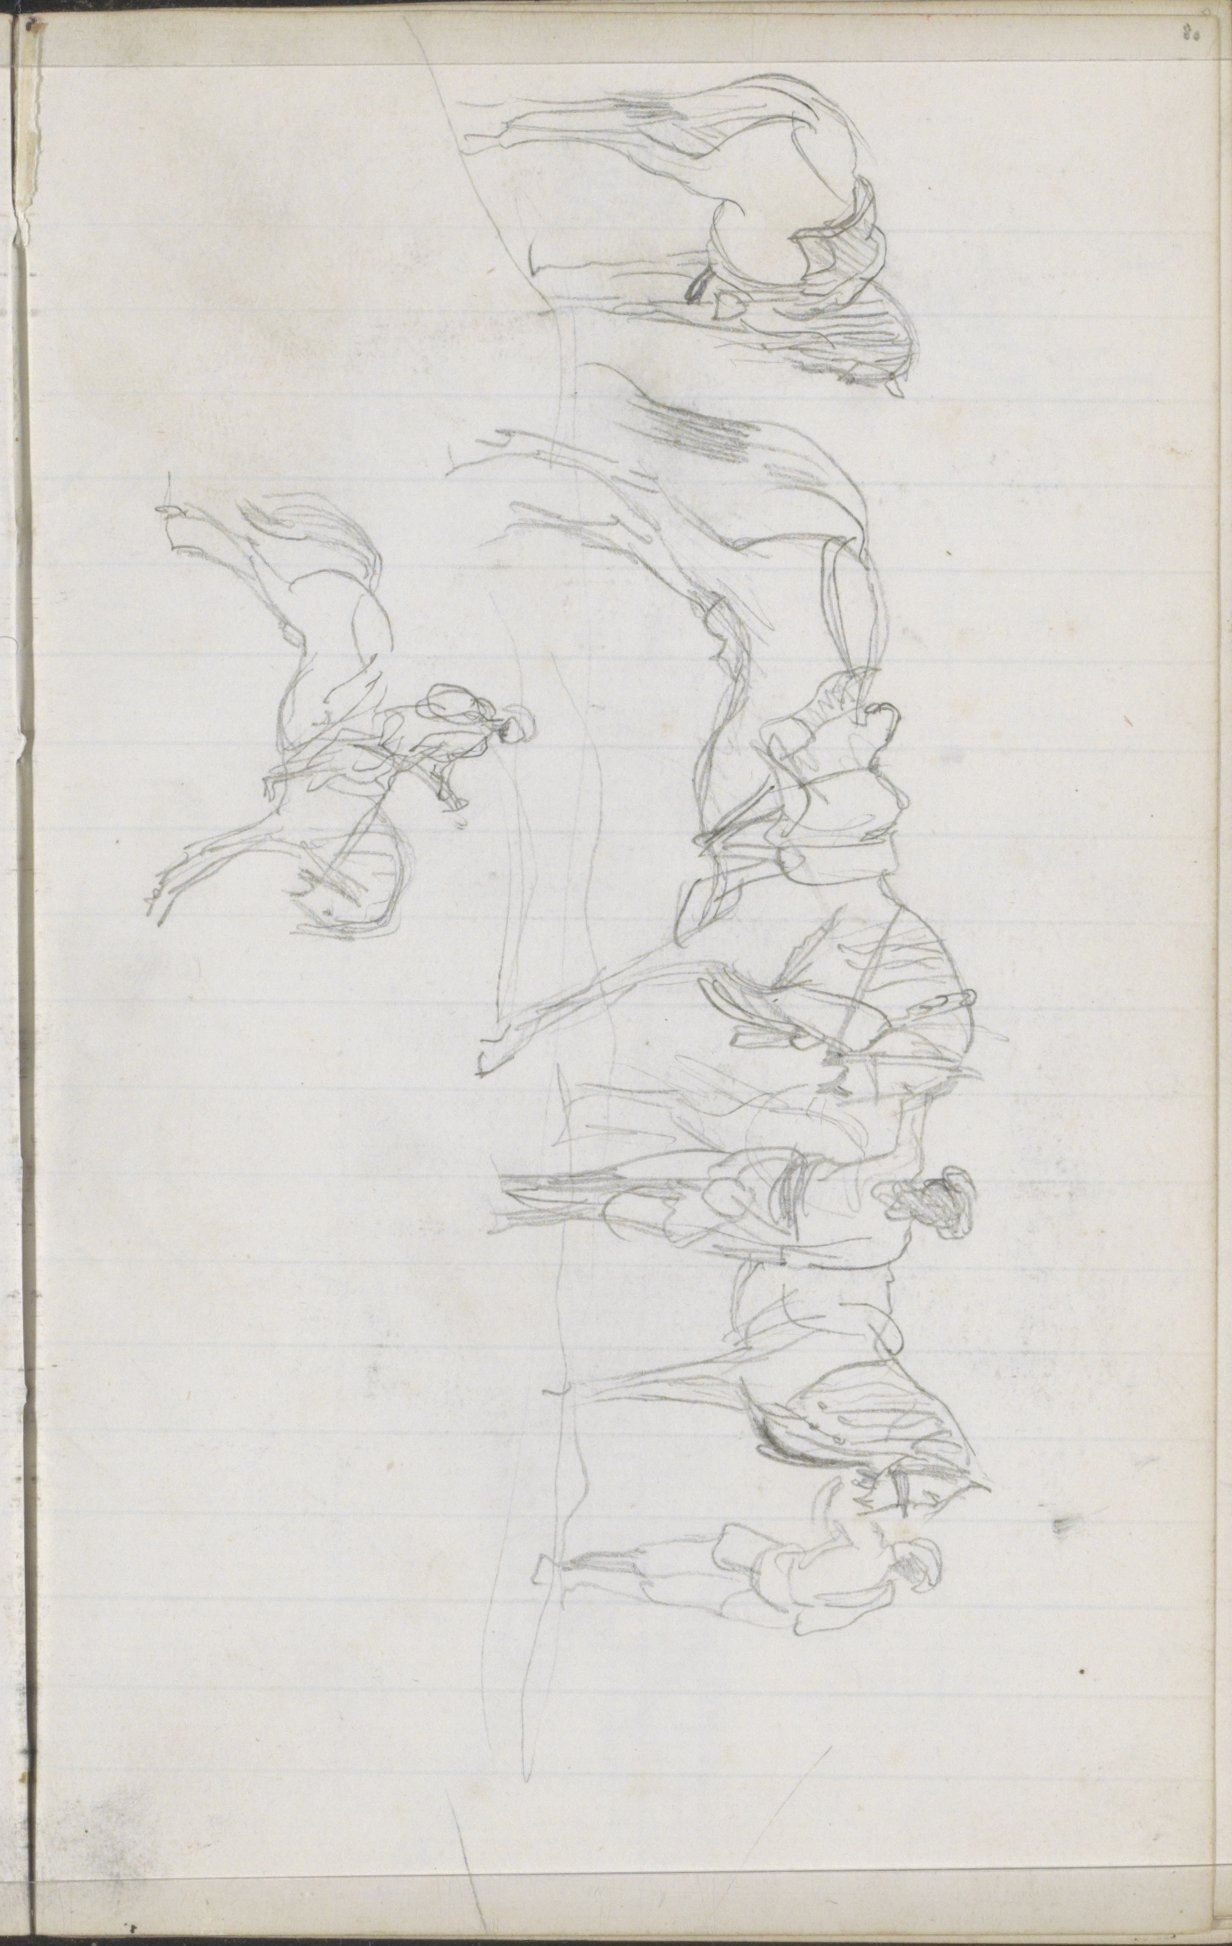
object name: sketchbook leaf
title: Indiërs met gezadelde paarden, waaronder één ruiter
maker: marius bauer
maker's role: draughtsman, print maker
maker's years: 1867-1932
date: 1897-1898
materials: pencil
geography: india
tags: riding a horse, ass, or mule; rider, horseman, saddle and bridle (saddlery), horse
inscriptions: kleurnotitie, handgeschreven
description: Pagina 80 uit een schetsboek met 62 bladen.